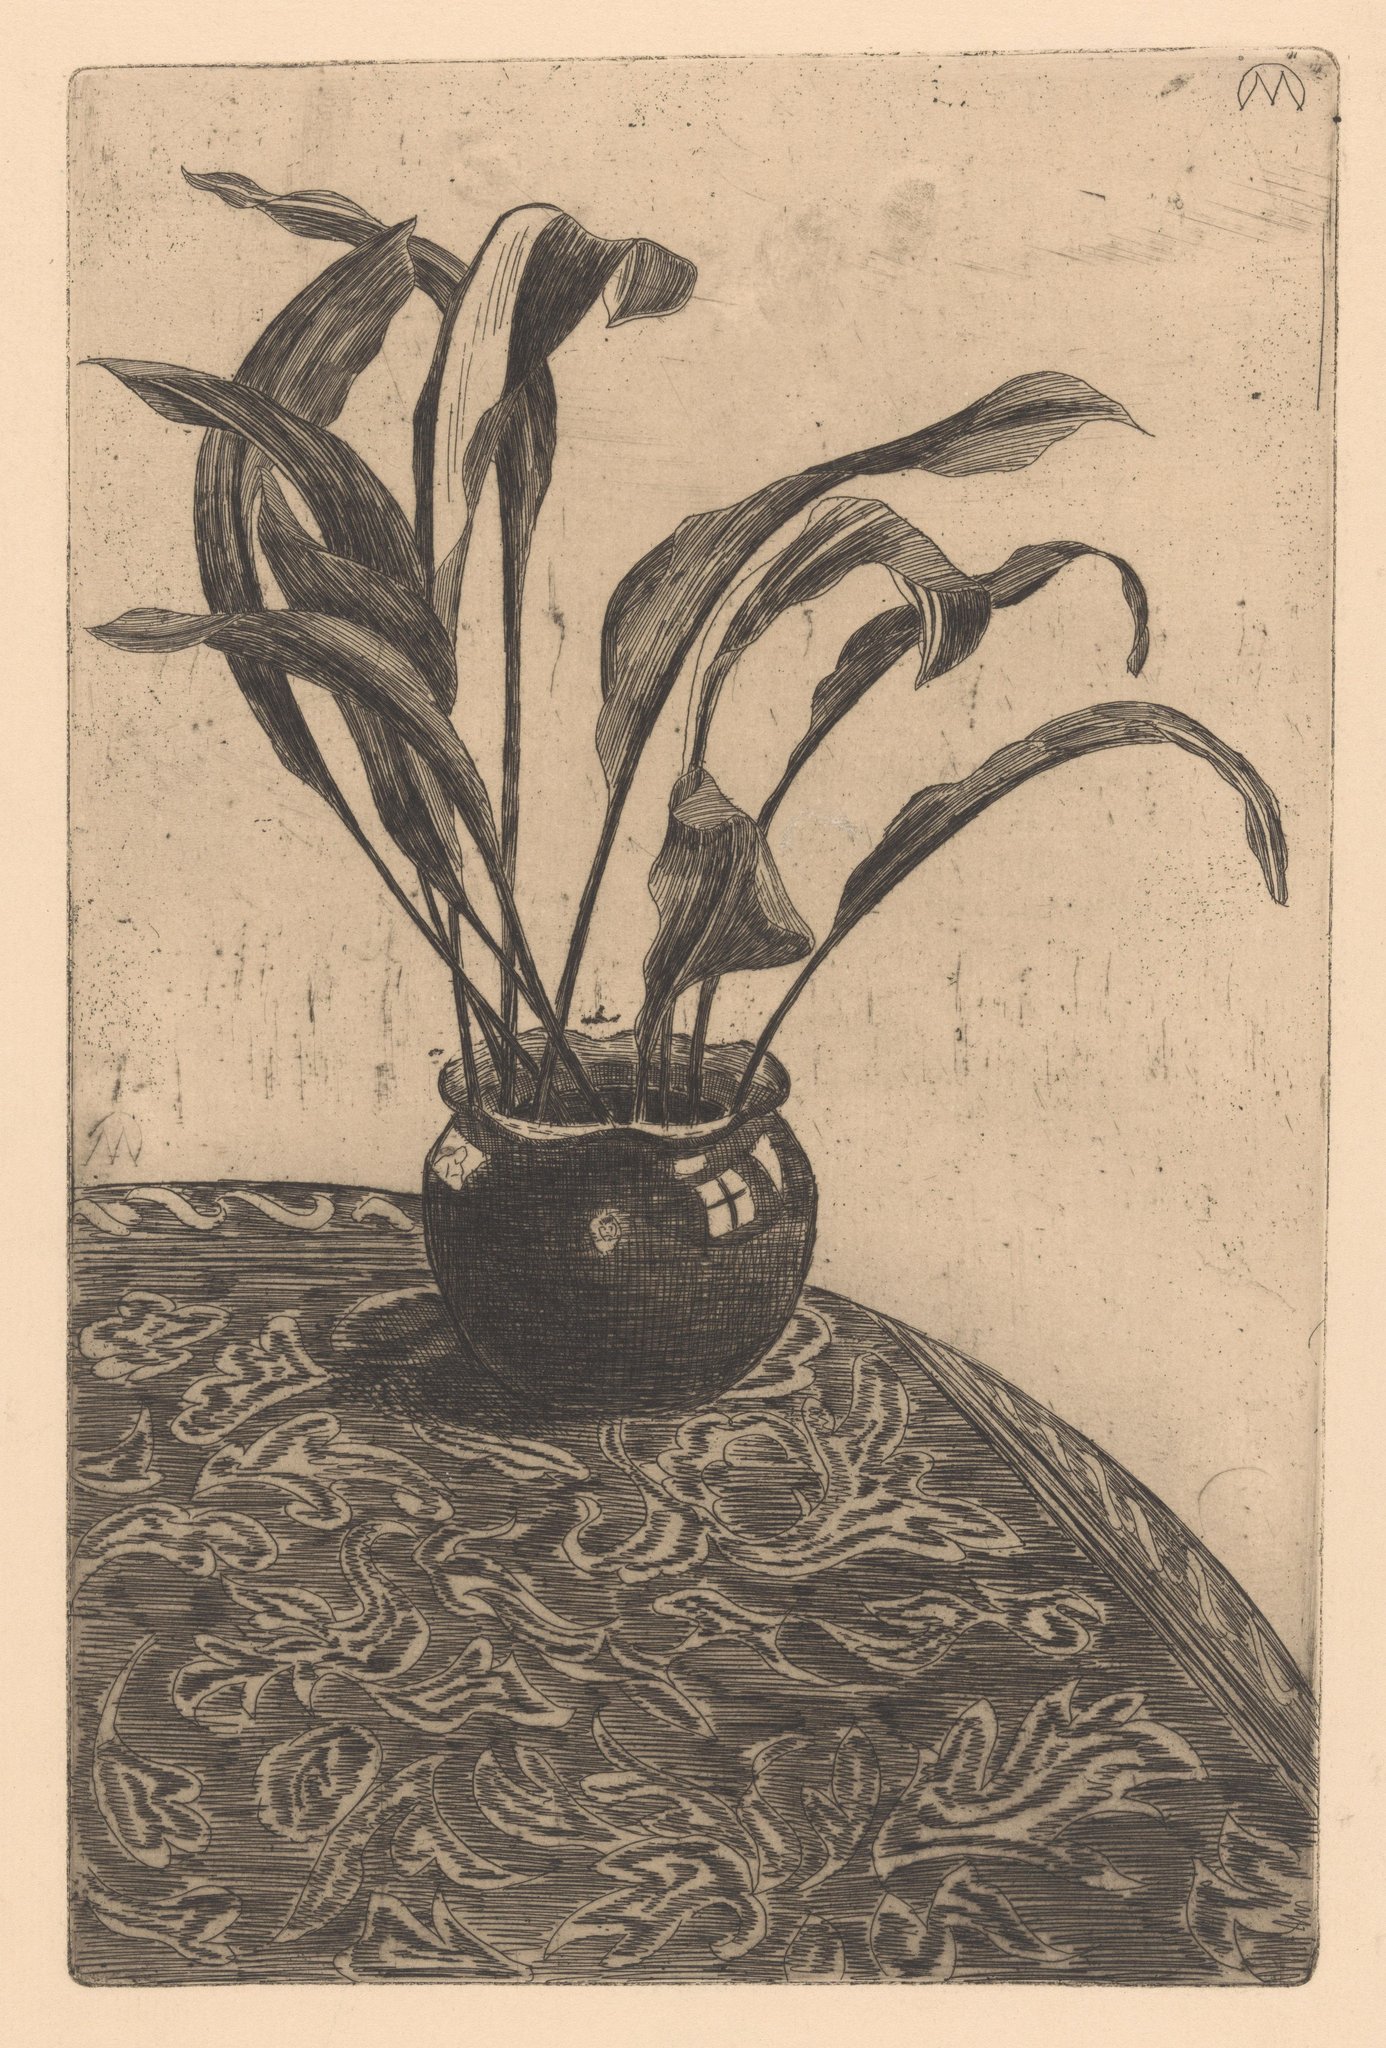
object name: print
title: Aspidistra elatior op ronde tafel met kleed (klein zelfportret)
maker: samuel jessurun de mesquita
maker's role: draughtsman, print maker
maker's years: 1868-1944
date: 1895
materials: paper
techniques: etching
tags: portrait, self-portrait of artist, potted plants, reflection (light in general)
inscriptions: collector's mark: Lugt 2228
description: Kamerplant in pot op tafel met kleed. In de weerkaatsing van de pot een gezicht.